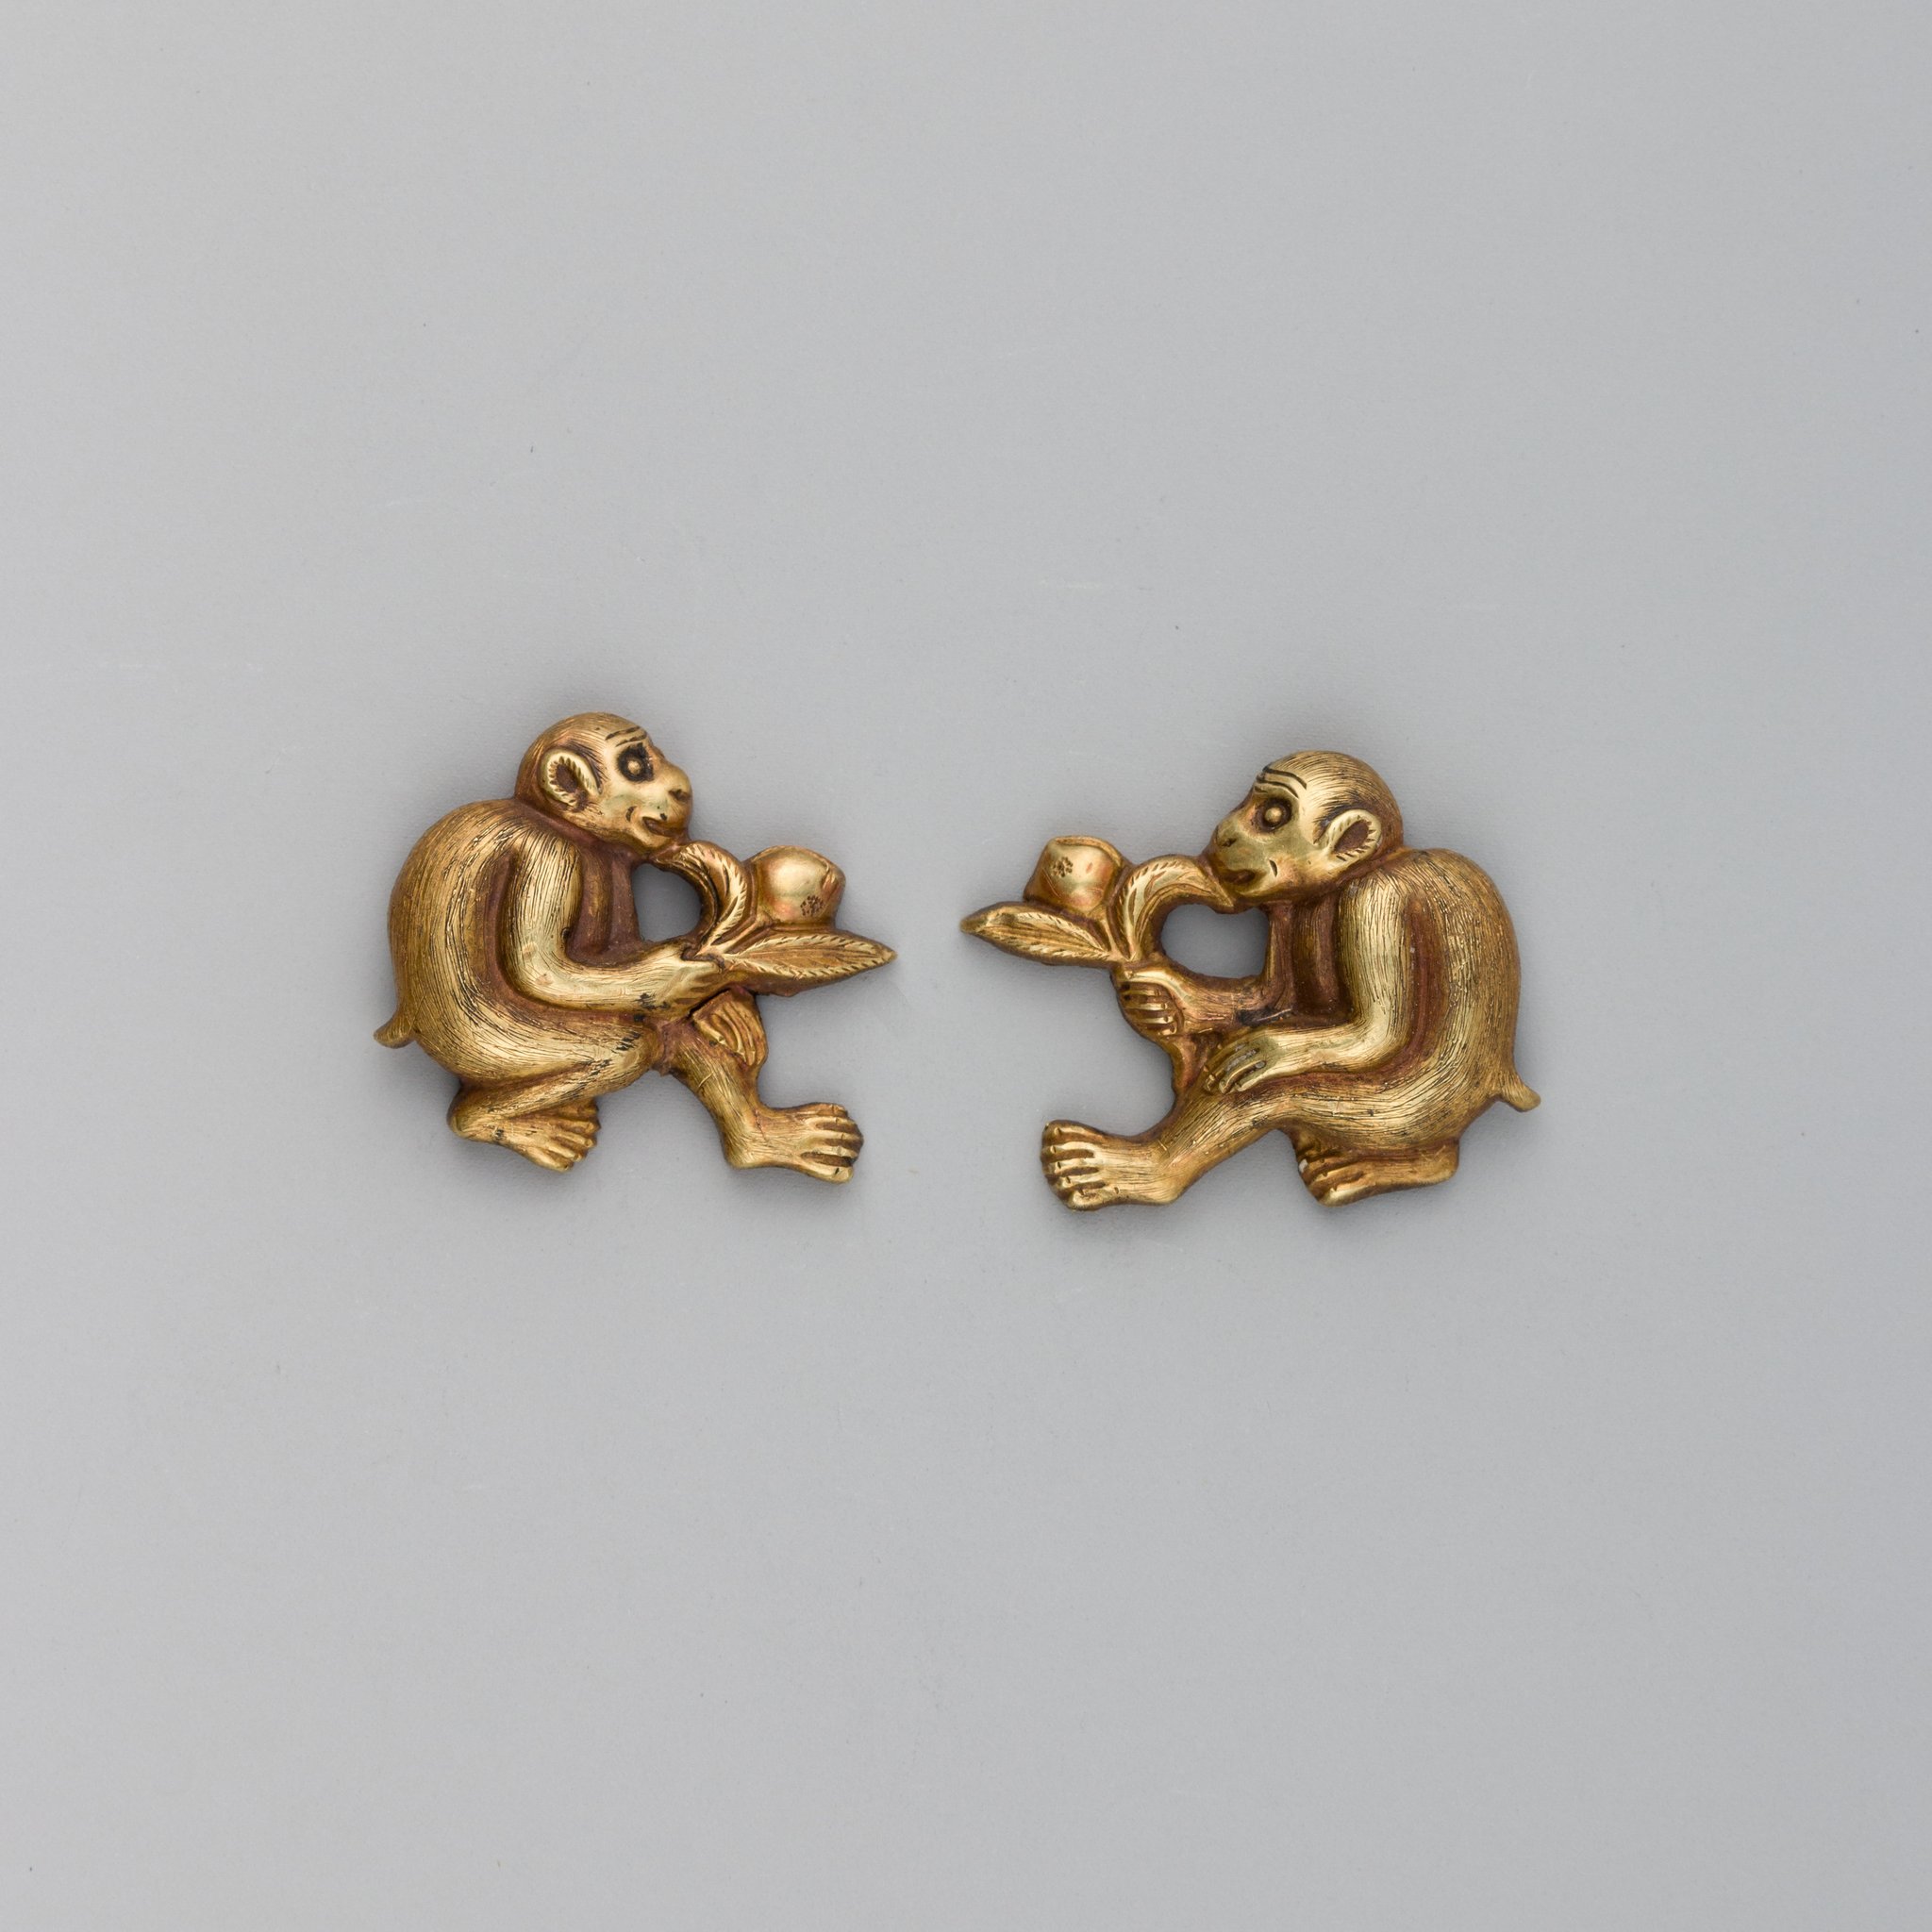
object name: pair of sword grip ornament menuki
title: Pair of Sword-Grip Ornaments (Menuki)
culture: japanese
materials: gold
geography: japan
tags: monkeys